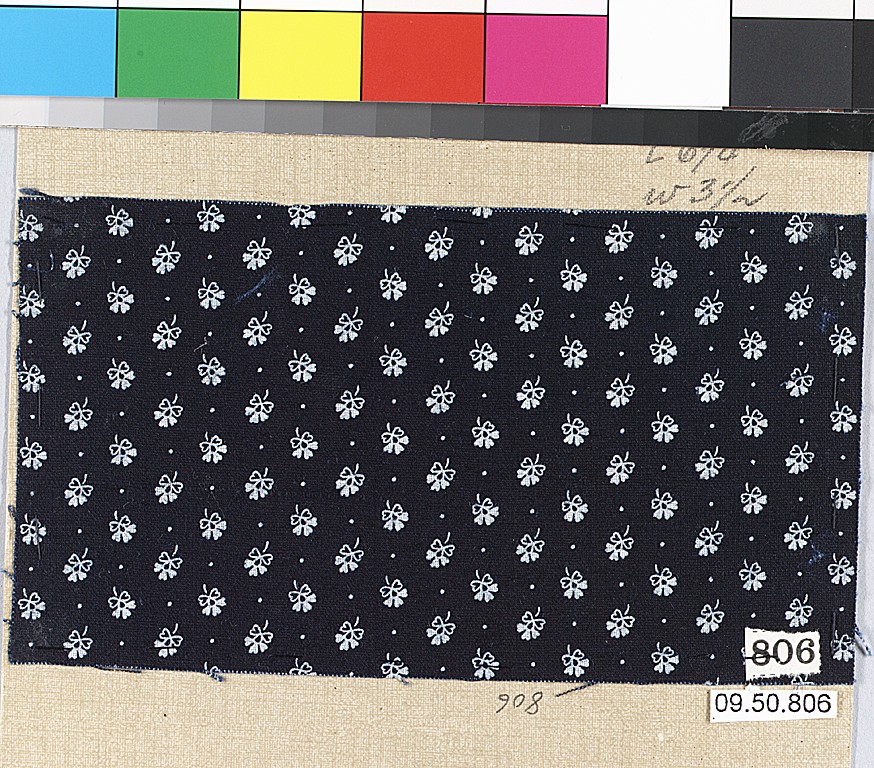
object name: piece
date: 1801-1900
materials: cotton